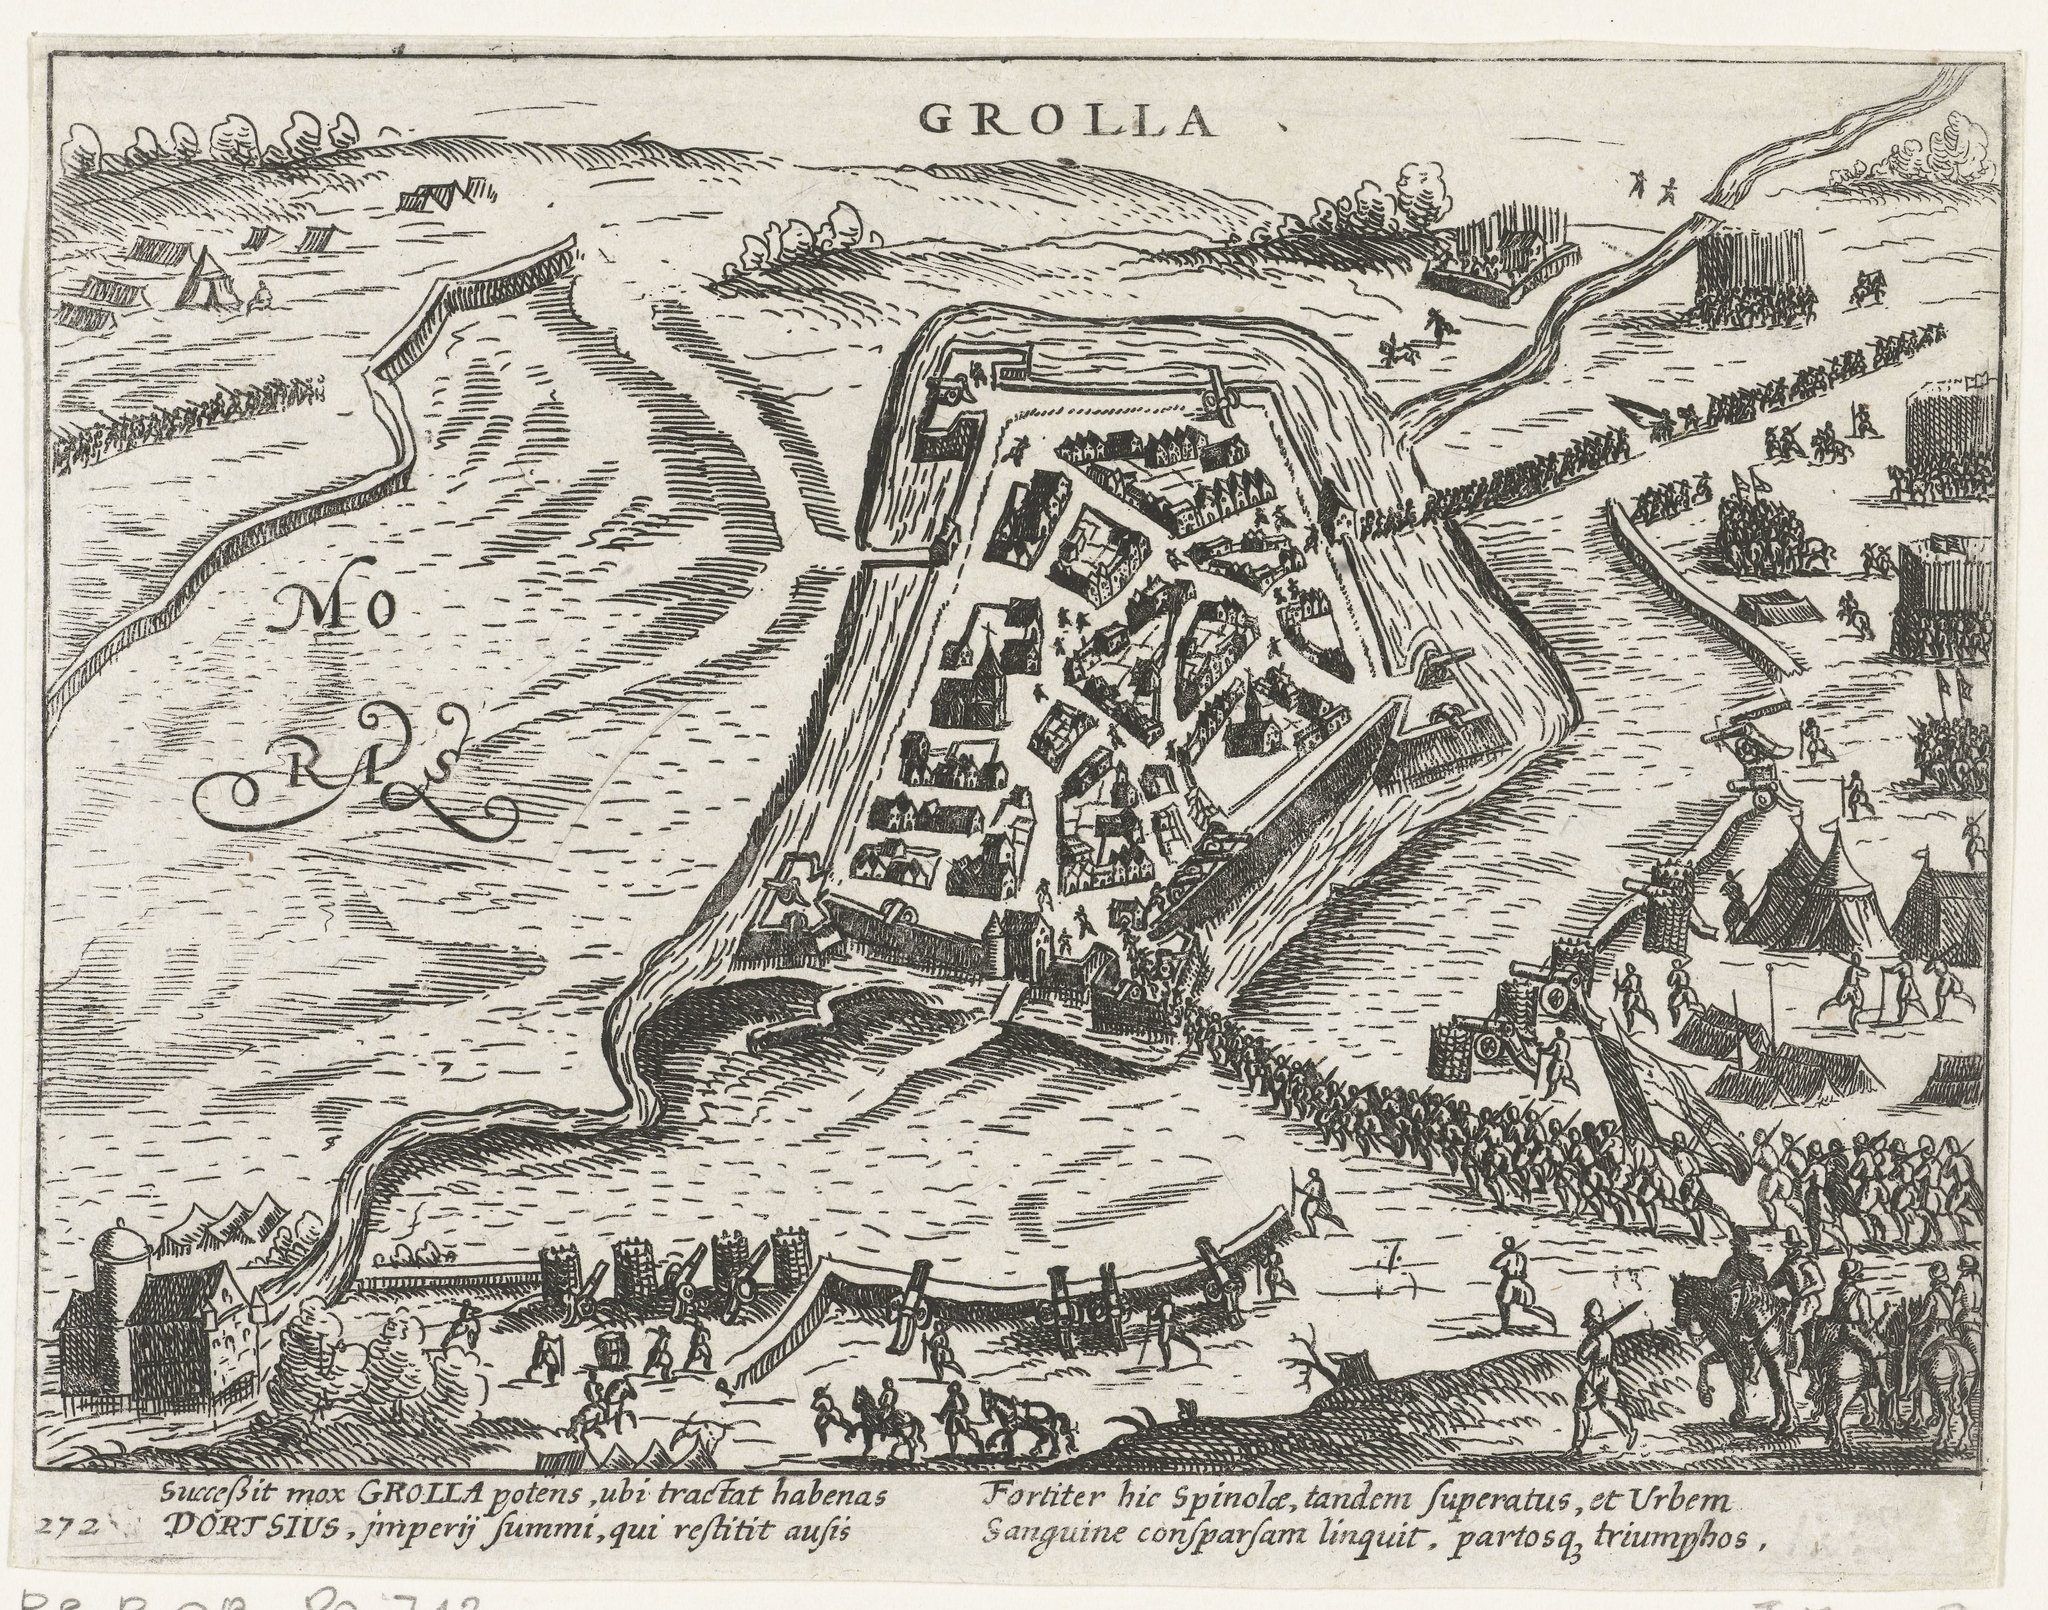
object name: print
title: Beleg en inname van Grol, 1606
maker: Anonymous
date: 1613-1615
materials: paper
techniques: etching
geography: northern netherlands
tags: siege, position war, capture of city (after the siege)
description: Beleg en inname van de stad Grol / Groenlo door het Spaanse leger onder Spinola, 5-14 augustus 1606. Plan de stad met het omliggende land met het legerkamp van het leger van Spinola. Onderaan trekt het Spaanse leger de stad, terwijl daarboven het Staatse leger de stad verlaat. Met onderschrift van 4 regels in het Latijn. Genummerd: 272. Bedrukt op achterzijde met tekst in het Latijn.